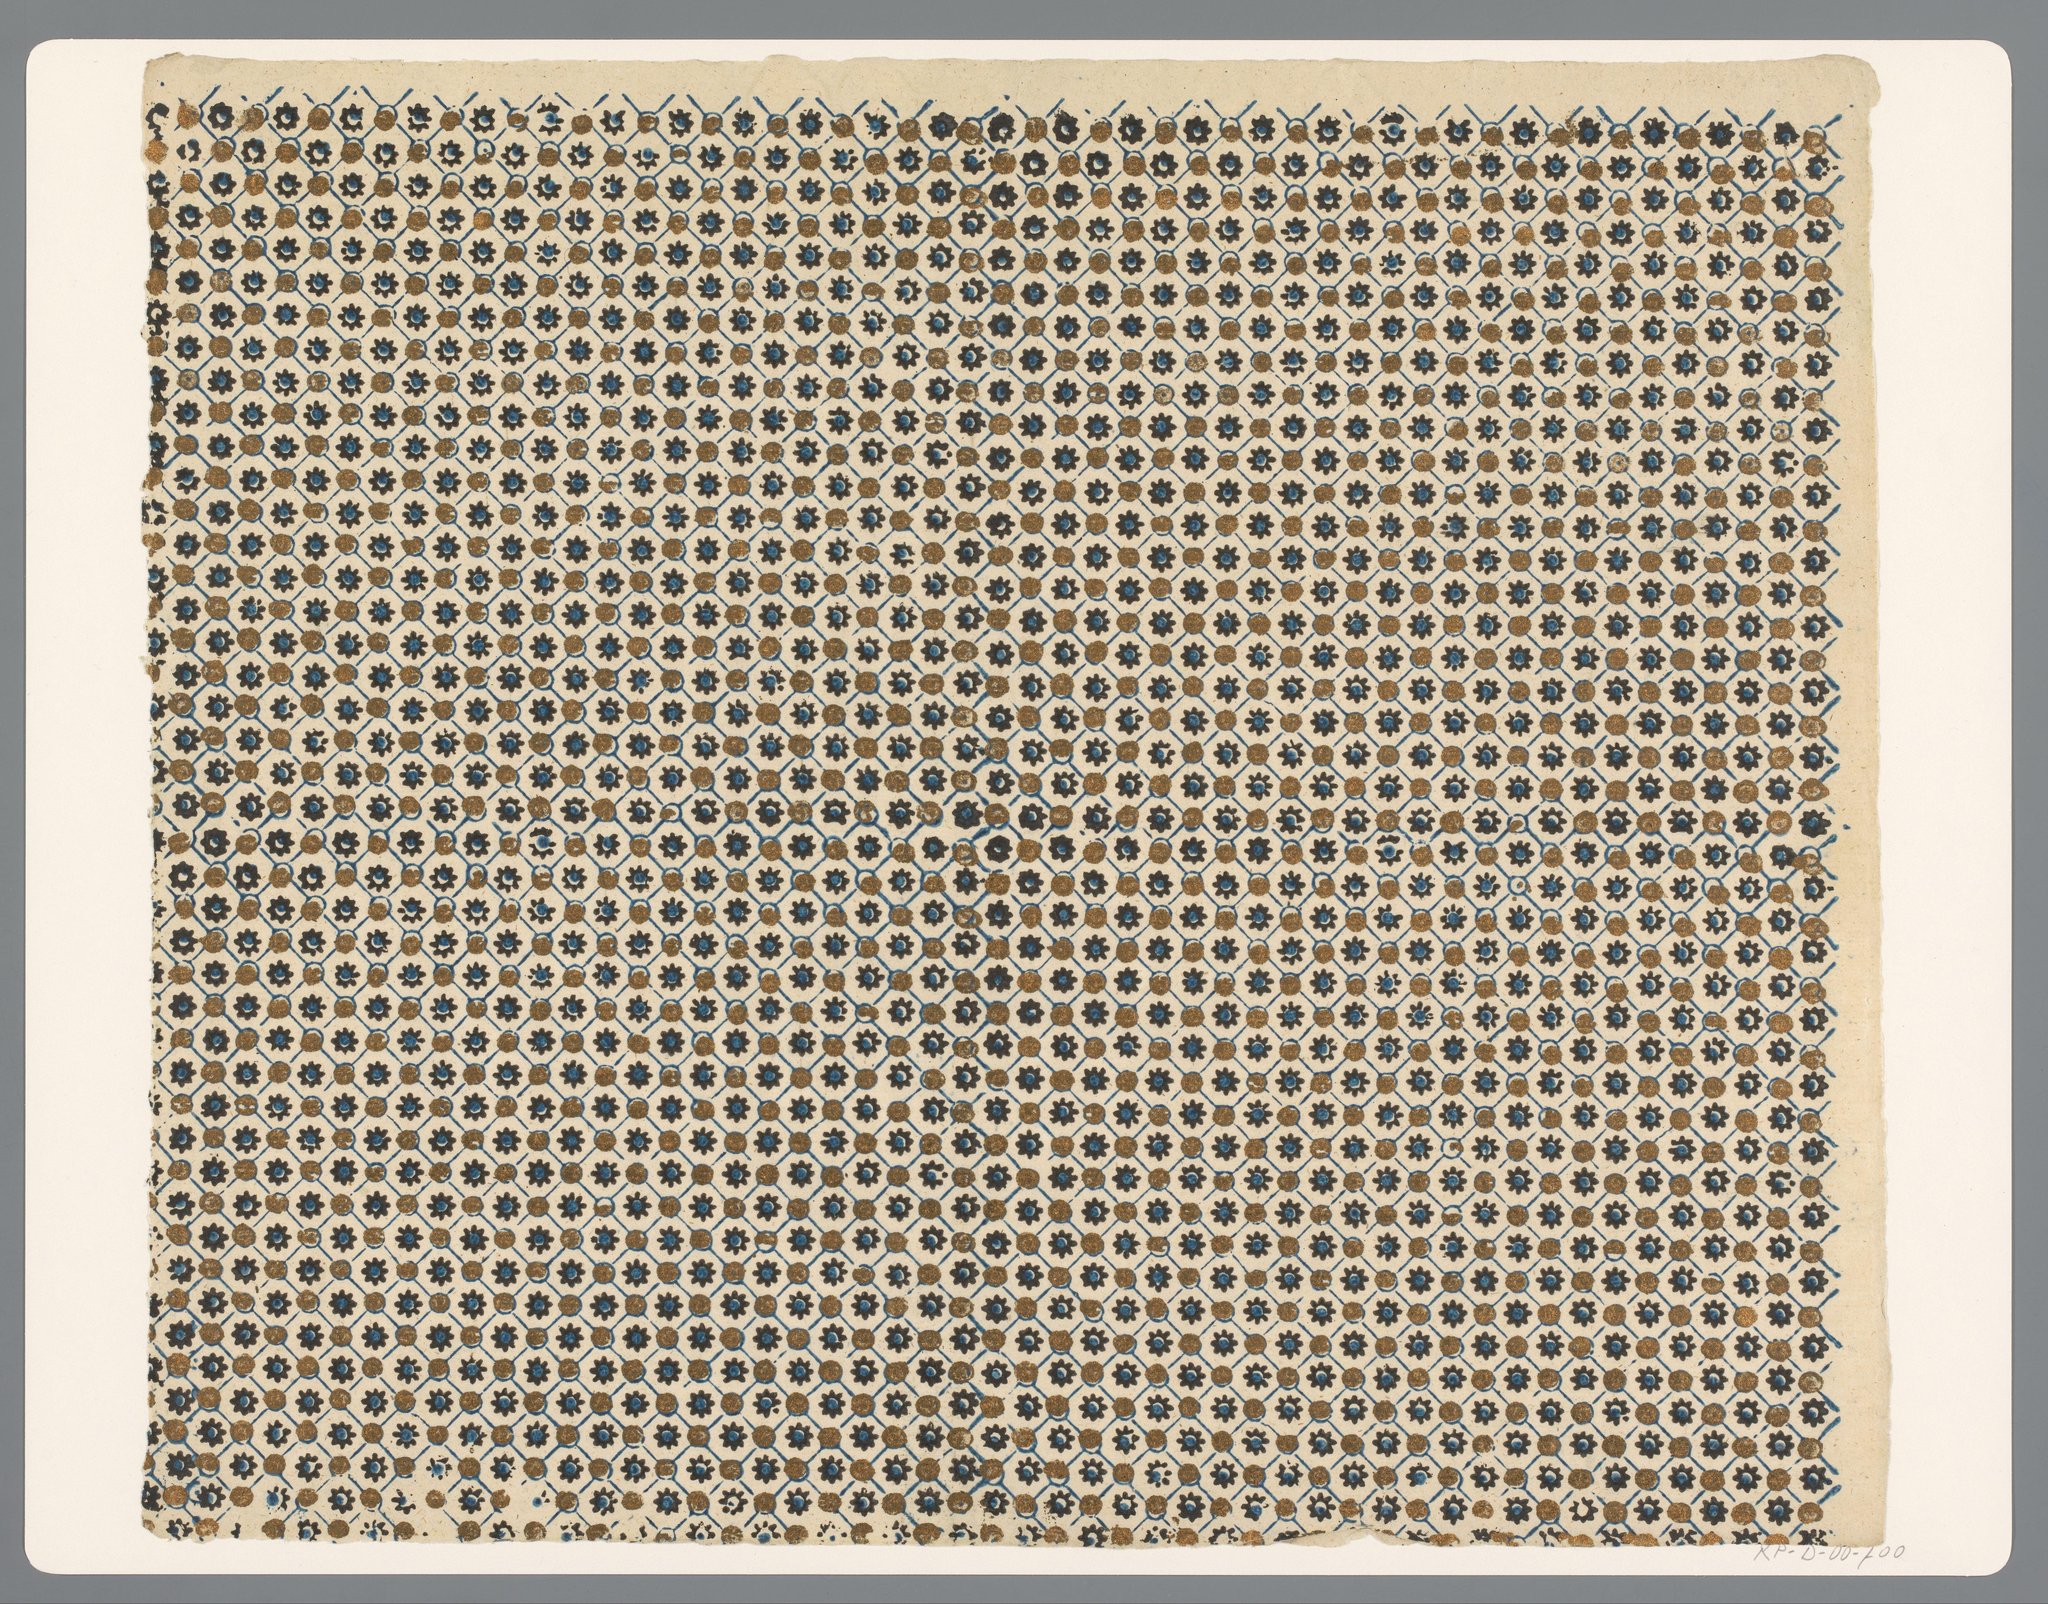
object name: printed paper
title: Blad met ruitenpatroon met als veldvulling rozet en overhoekse stippen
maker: Anonymous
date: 1750-1900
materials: paint, paper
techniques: printing block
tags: ornament derived from plant forms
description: Blad met ruitenpatroon met als veldvulling rozet en overhoekse stippen.